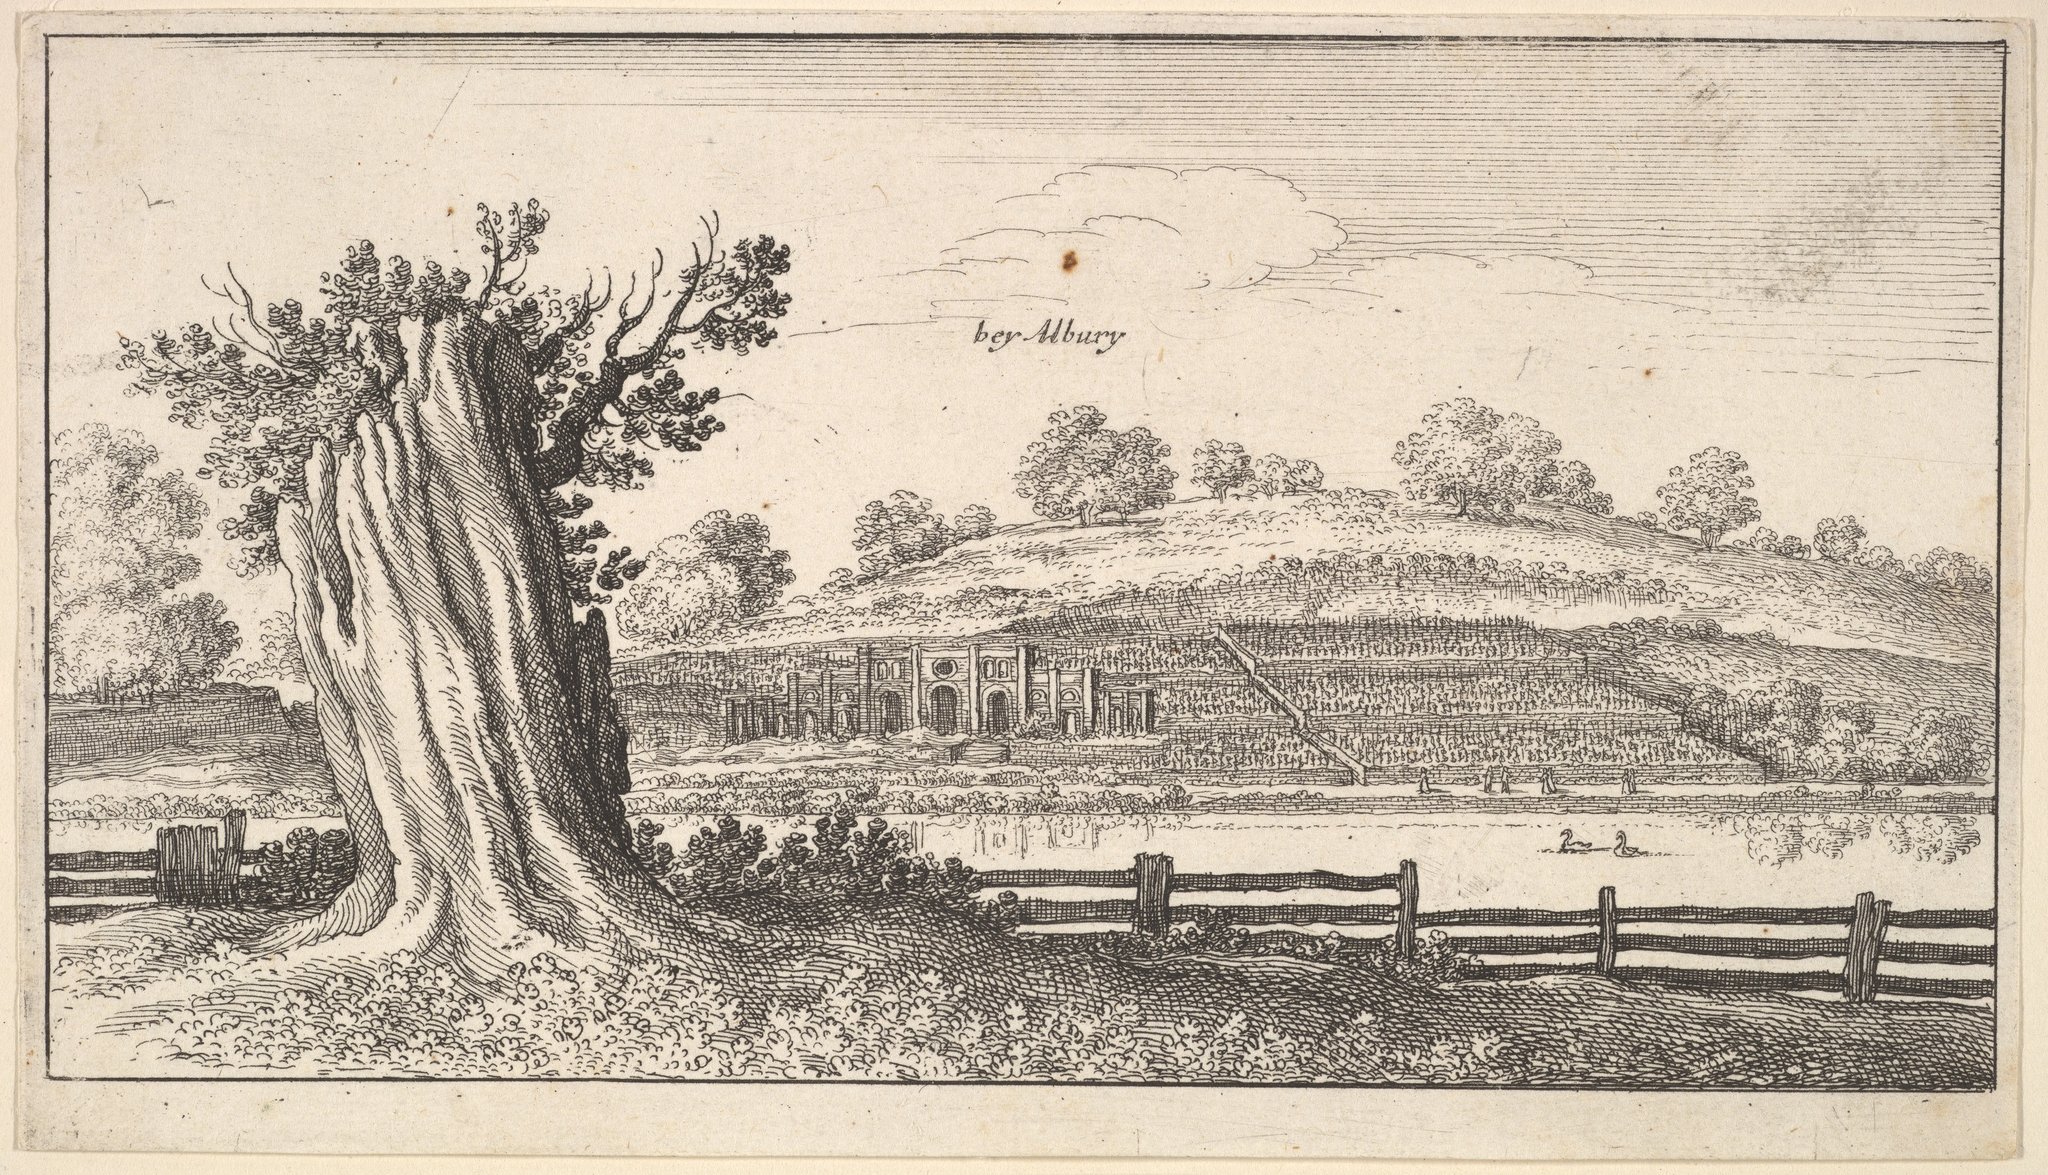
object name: print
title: Albury with tree-stump in foreground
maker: wenceslaus hollar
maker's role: artist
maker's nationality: bohemian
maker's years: 1607-1677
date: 1645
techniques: etching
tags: houses,trees